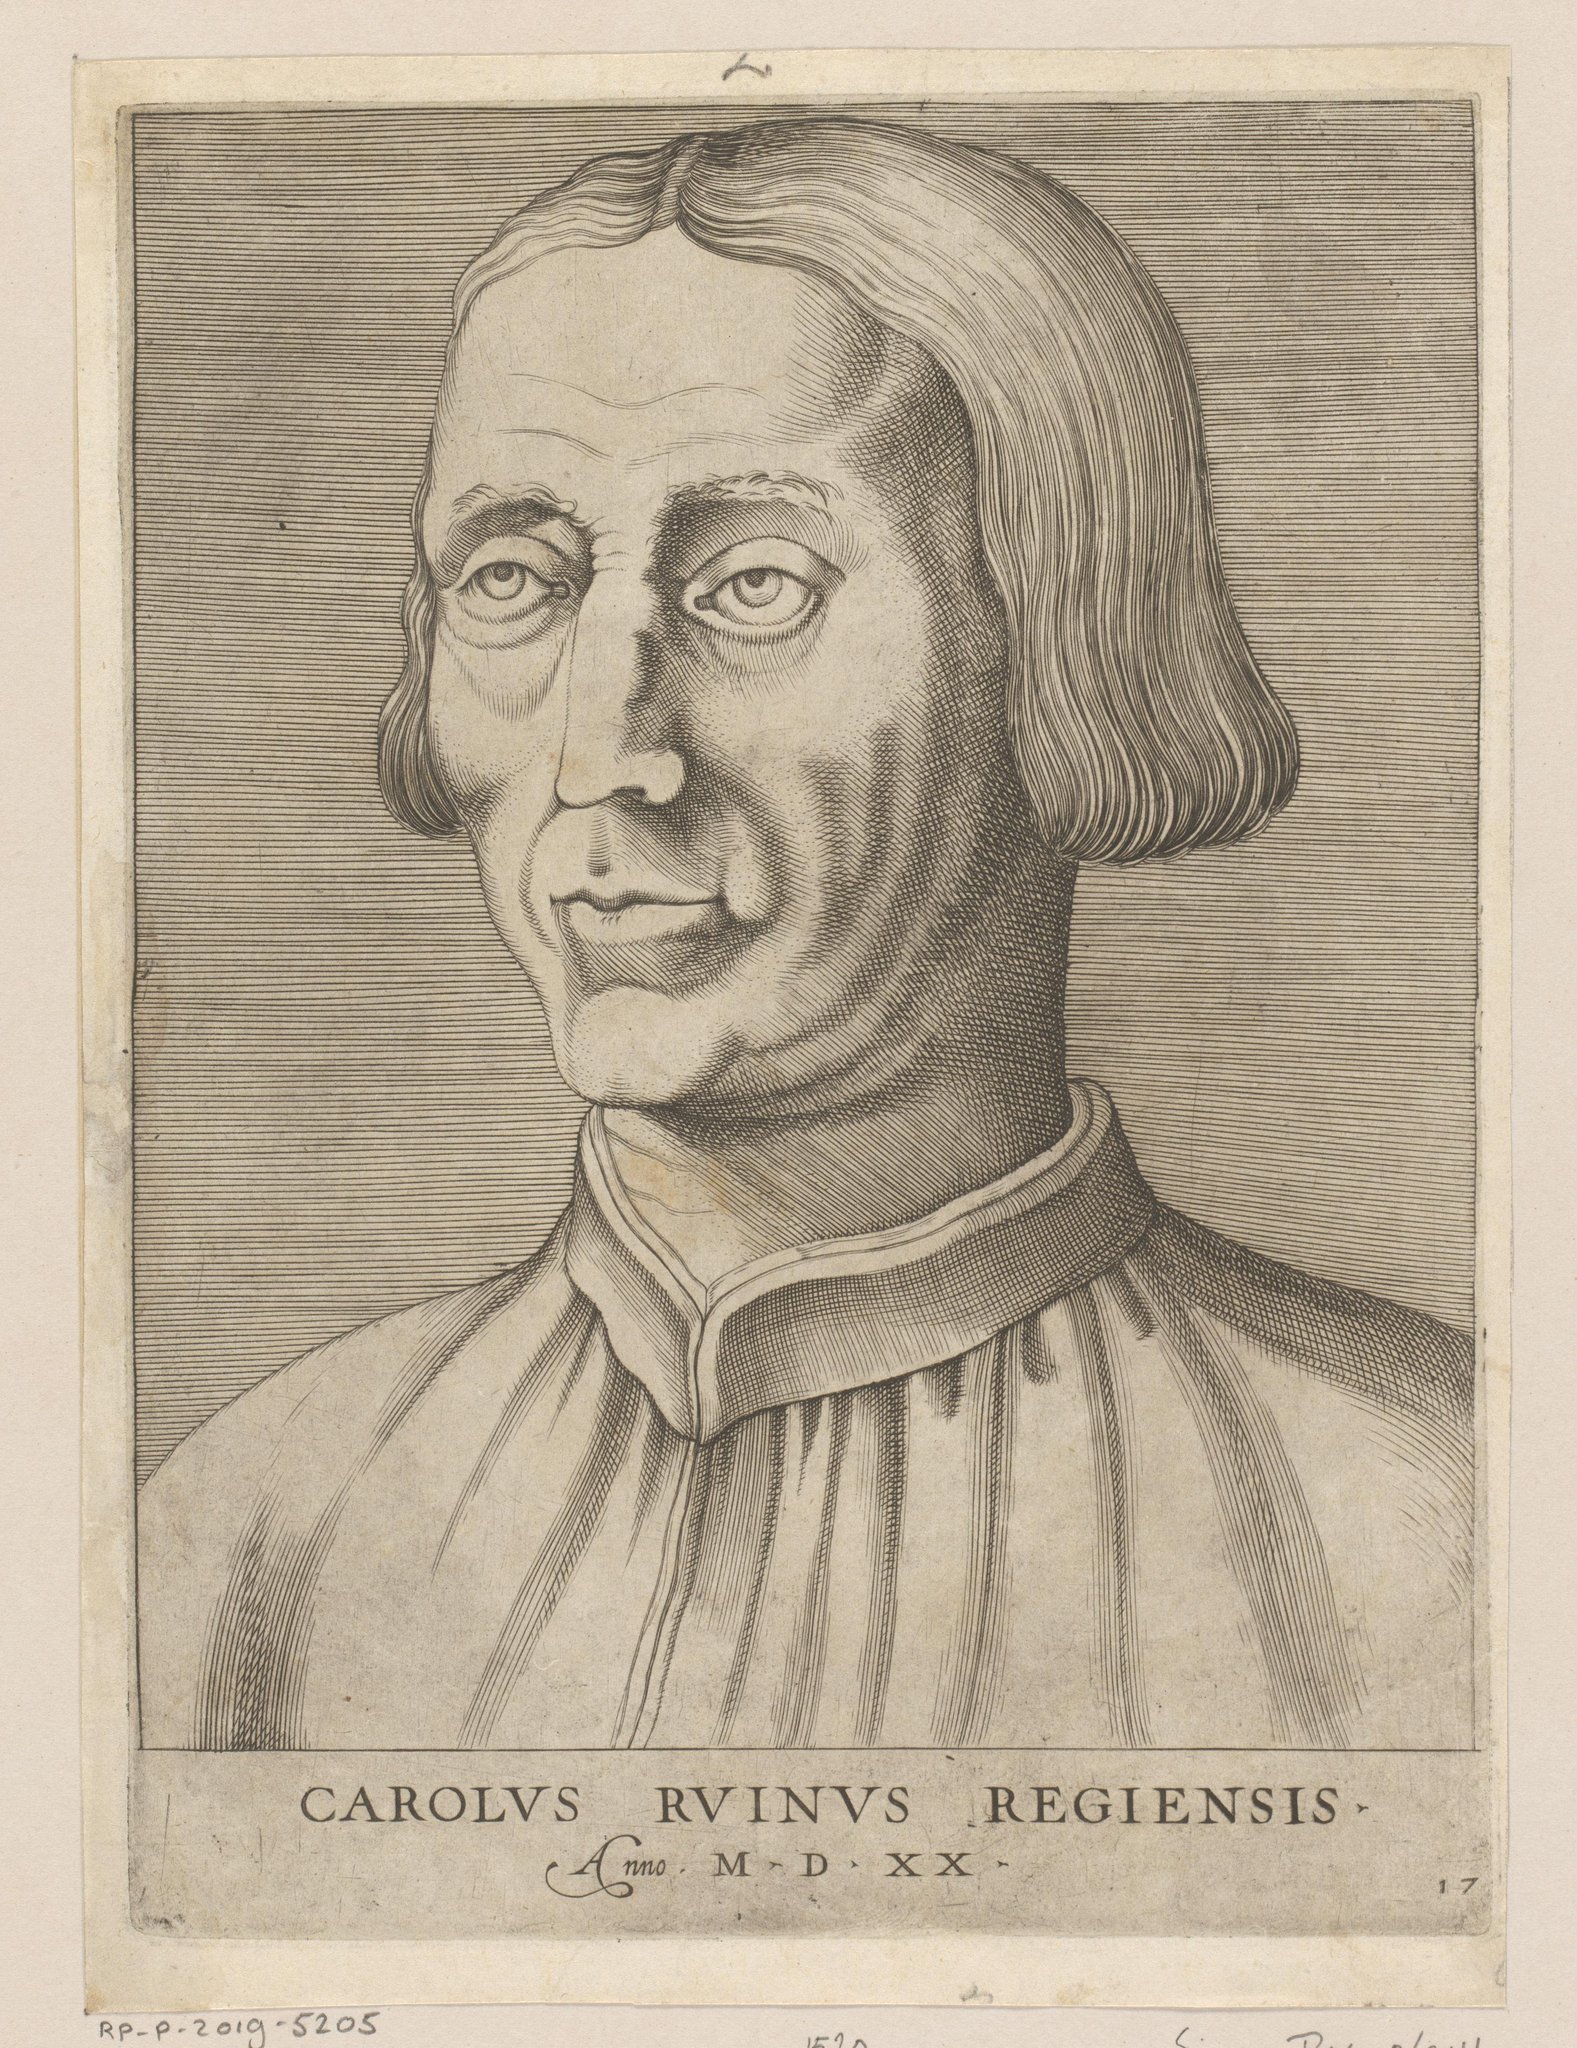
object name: print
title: Portret van Carlo Ruini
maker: Anonymous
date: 1566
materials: paper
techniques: engraving, intaglio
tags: historical persons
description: Prentserie voor het eerst uitgegeven te Rome door Antonio Lafreri in 1566. Serie waarschijnlijk opnieuw uitgegeven door Petri de' Nobili rond 1584-1585.